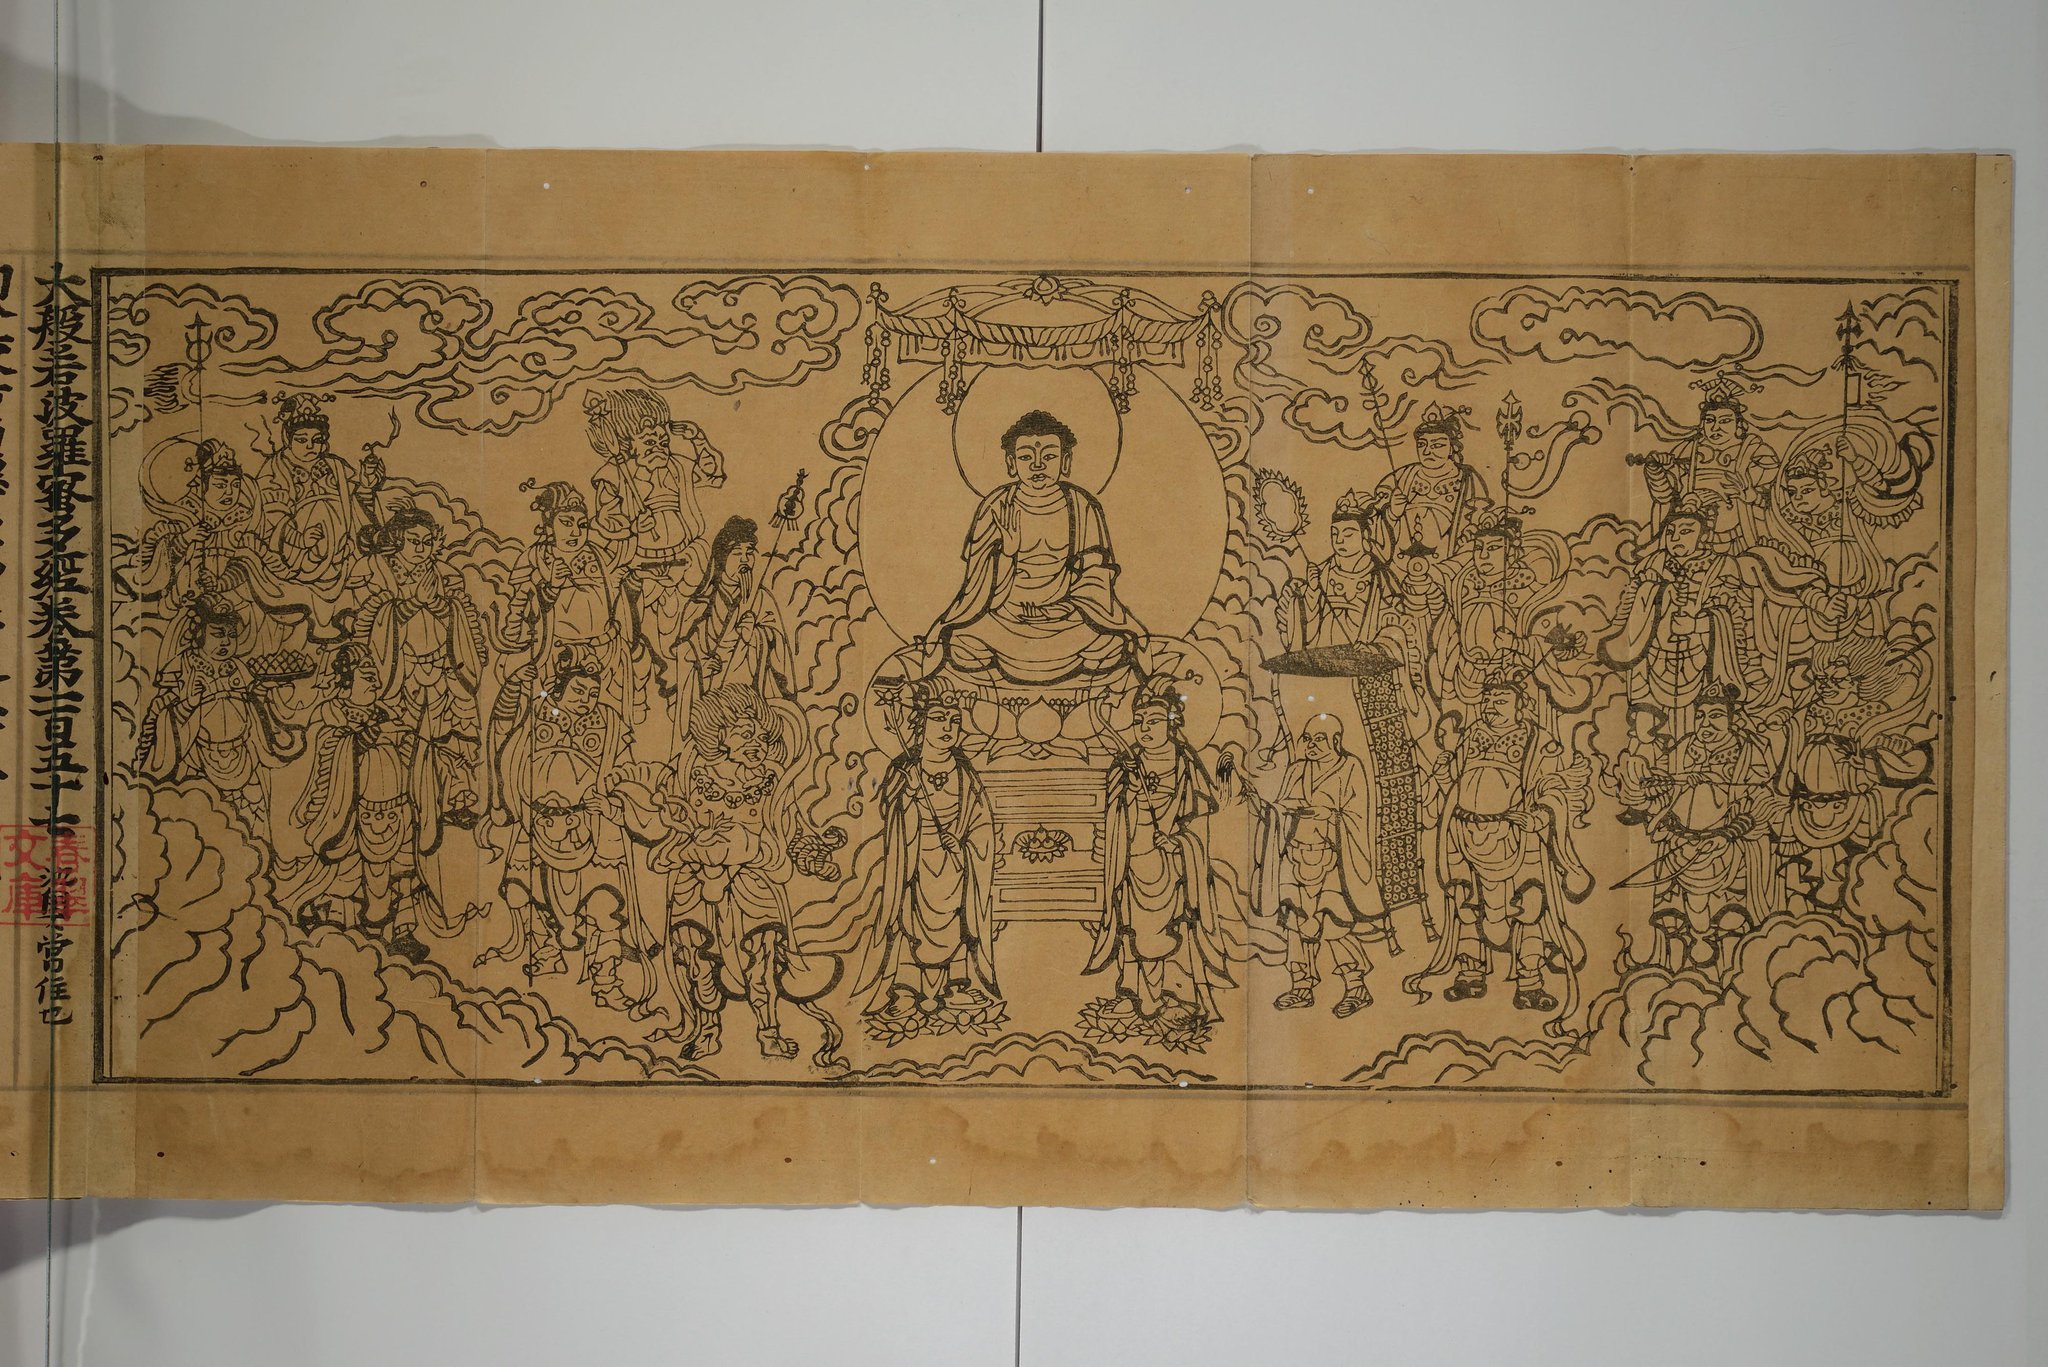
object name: sutra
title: Fragment of Vol. 157 of Sutra of the Perfection of Wisdom (Mahaprajnaparamita sutra; Daihannyaharamittakyō) 大般若波羅蜜多経巻第一百五十七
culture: japanese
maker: unidentified artist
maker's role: artist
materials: ink, paper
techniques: woodblock print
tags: buddhism,buddha